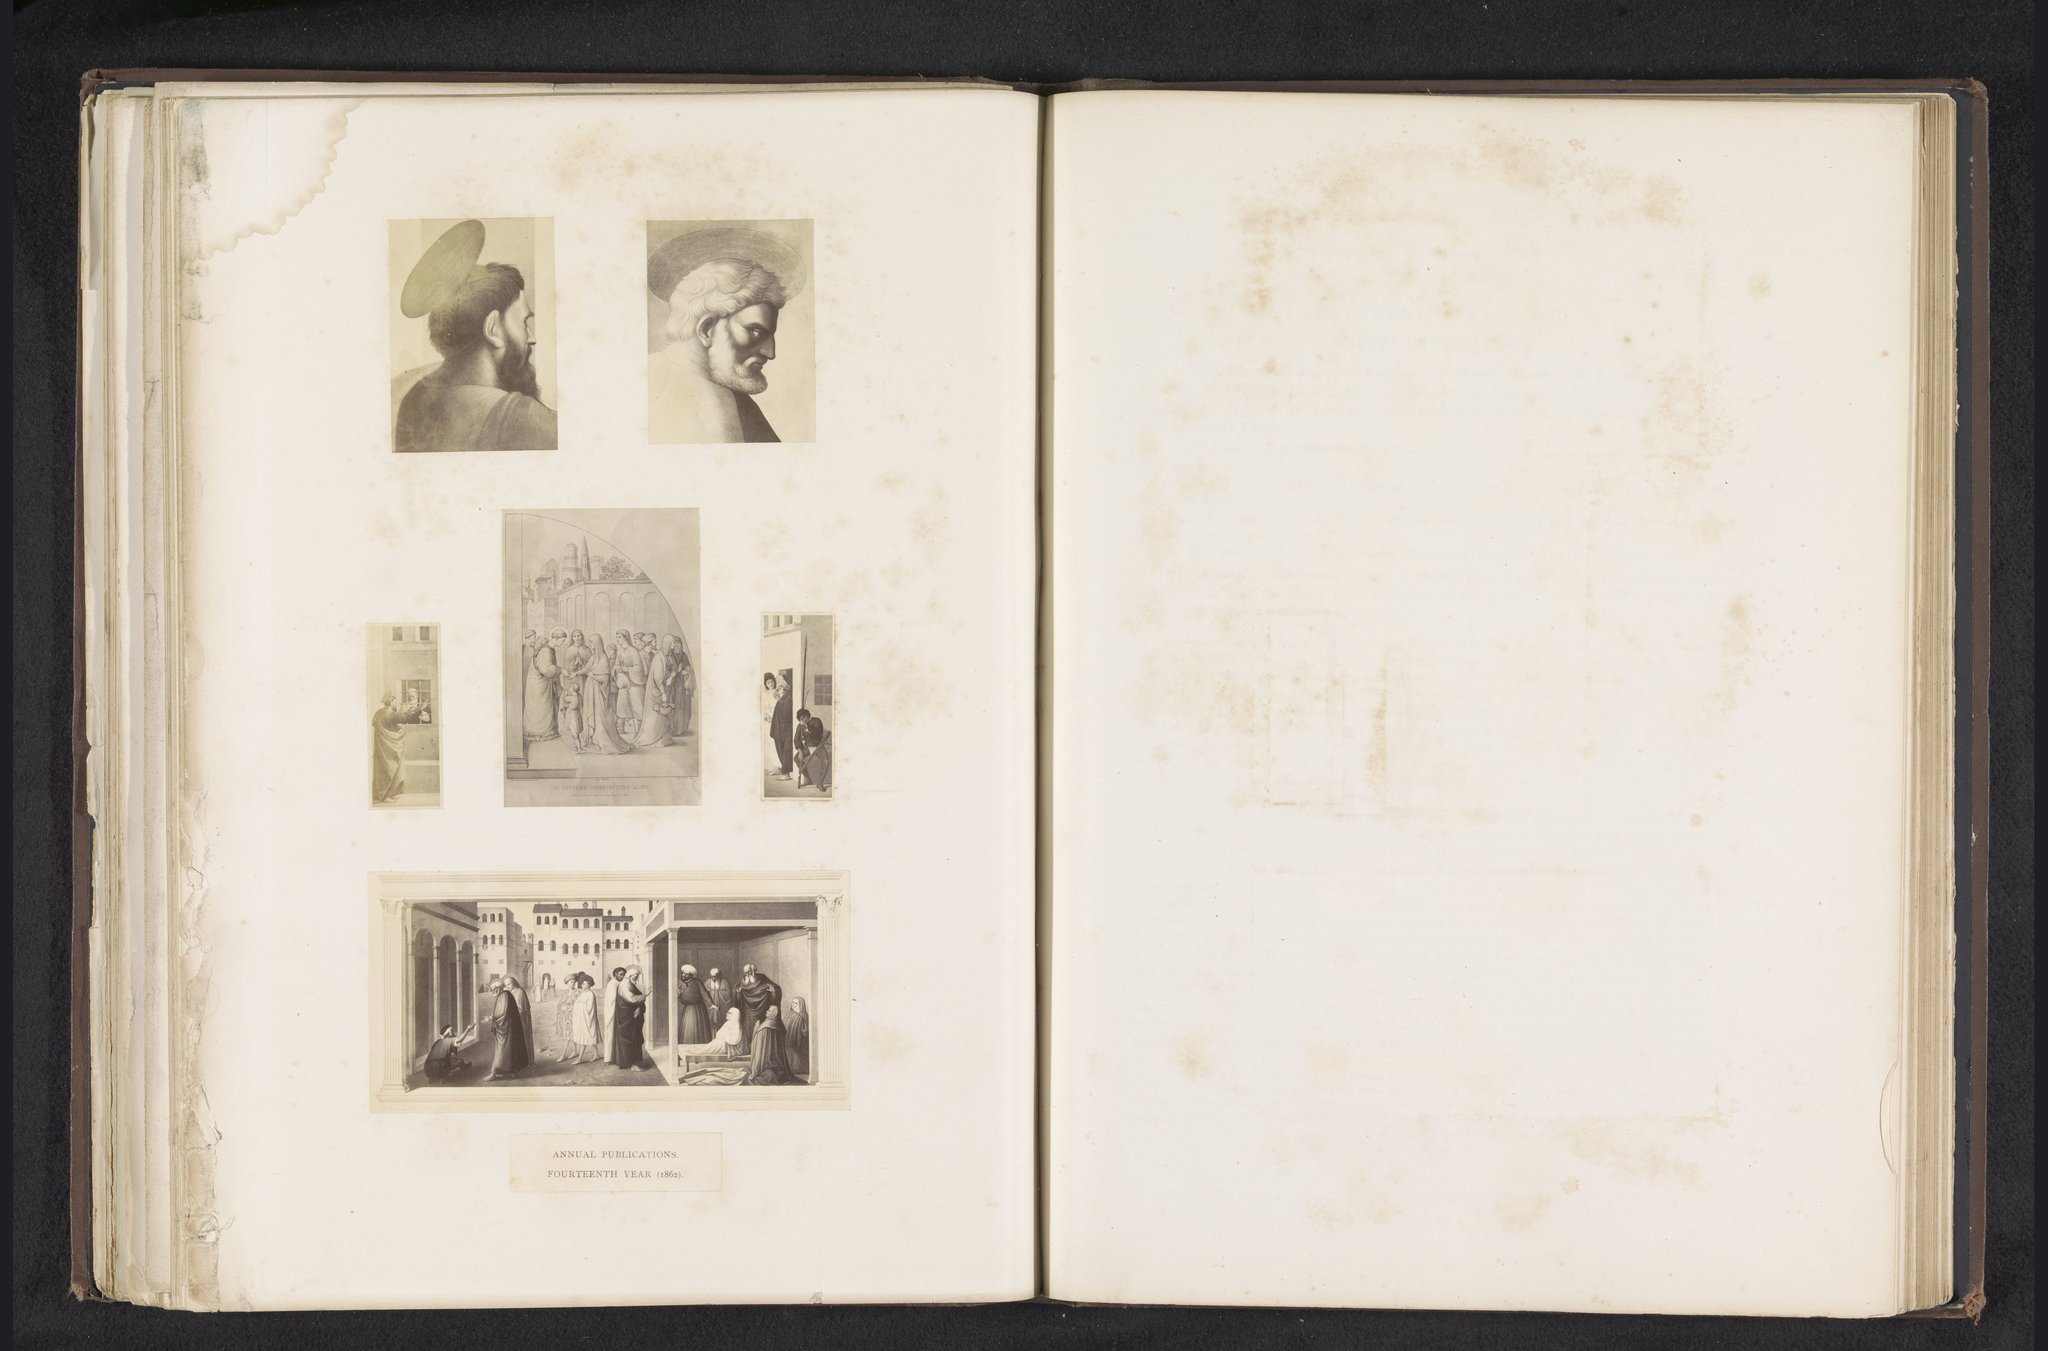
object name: page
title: Zes fotoreproducties van een publicatie door de Arundel Society met schilderijen door Masaccio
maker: Anonymous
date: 1859-1869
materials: photographic support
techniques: albumen print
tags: book, painting (including book-illumination, miniature-painting)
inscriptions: inscription: ‘Annual publications. Fourteenth year (1862).’